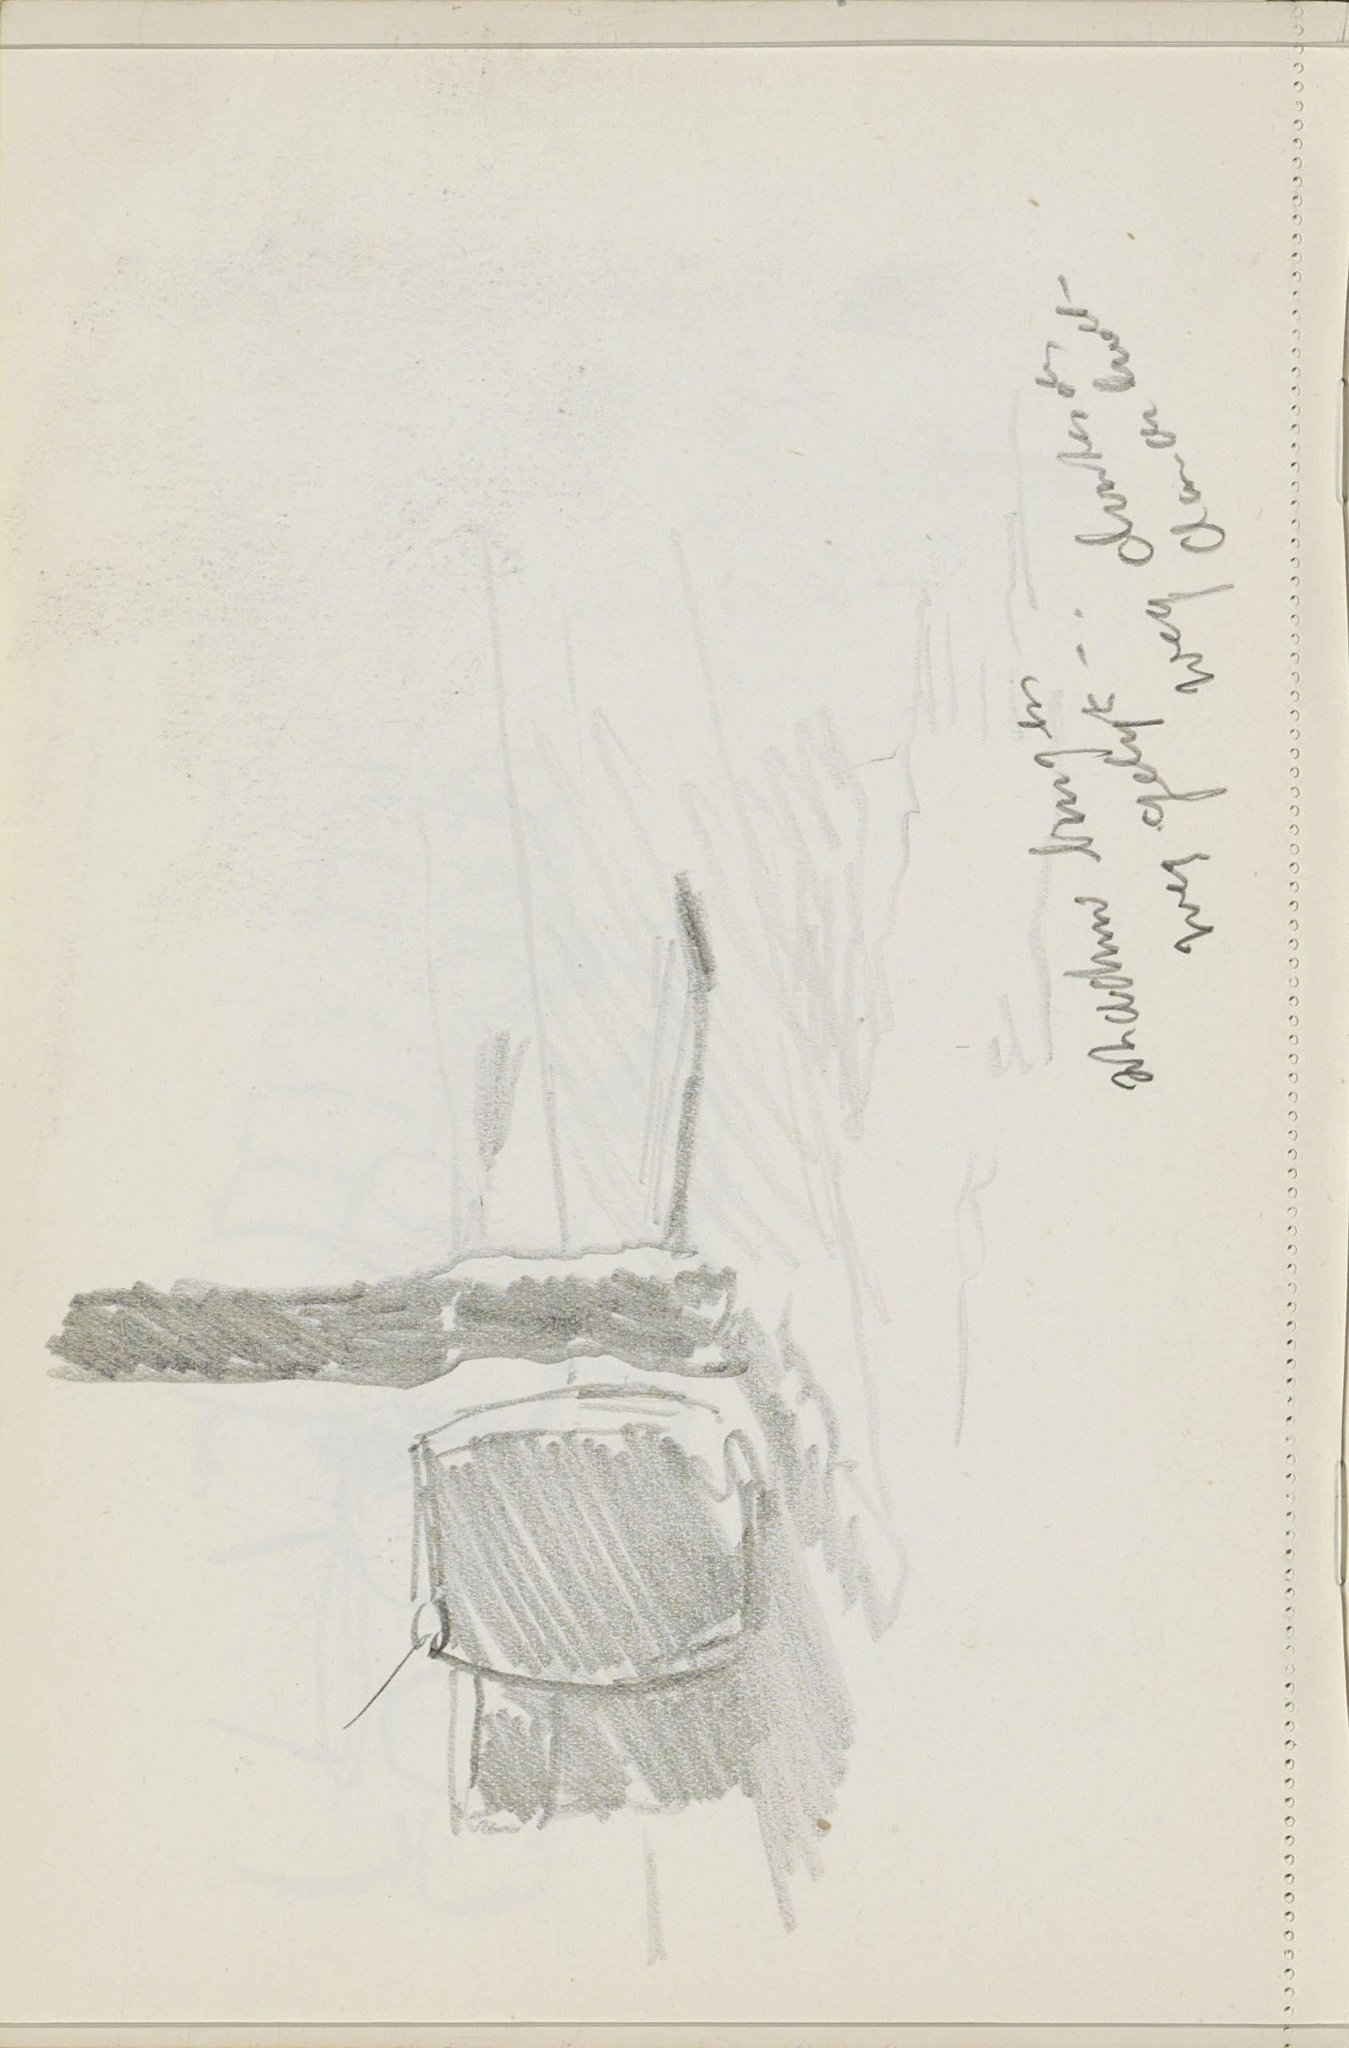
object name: sketchbook leaf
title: Tonnen bij een boomstam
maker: cornelis vreedenburgh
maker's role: draughtsman, print maker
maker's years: 1880-1946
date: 1890-1946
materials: paper, pencil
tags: wooden container: barrel, cask, bucket, trees (+ stem, trunk)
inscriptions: kleurnotitie, handgeschreven in potlood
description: Blad 64 verso uit een schetsboek met uit 75 bladen.